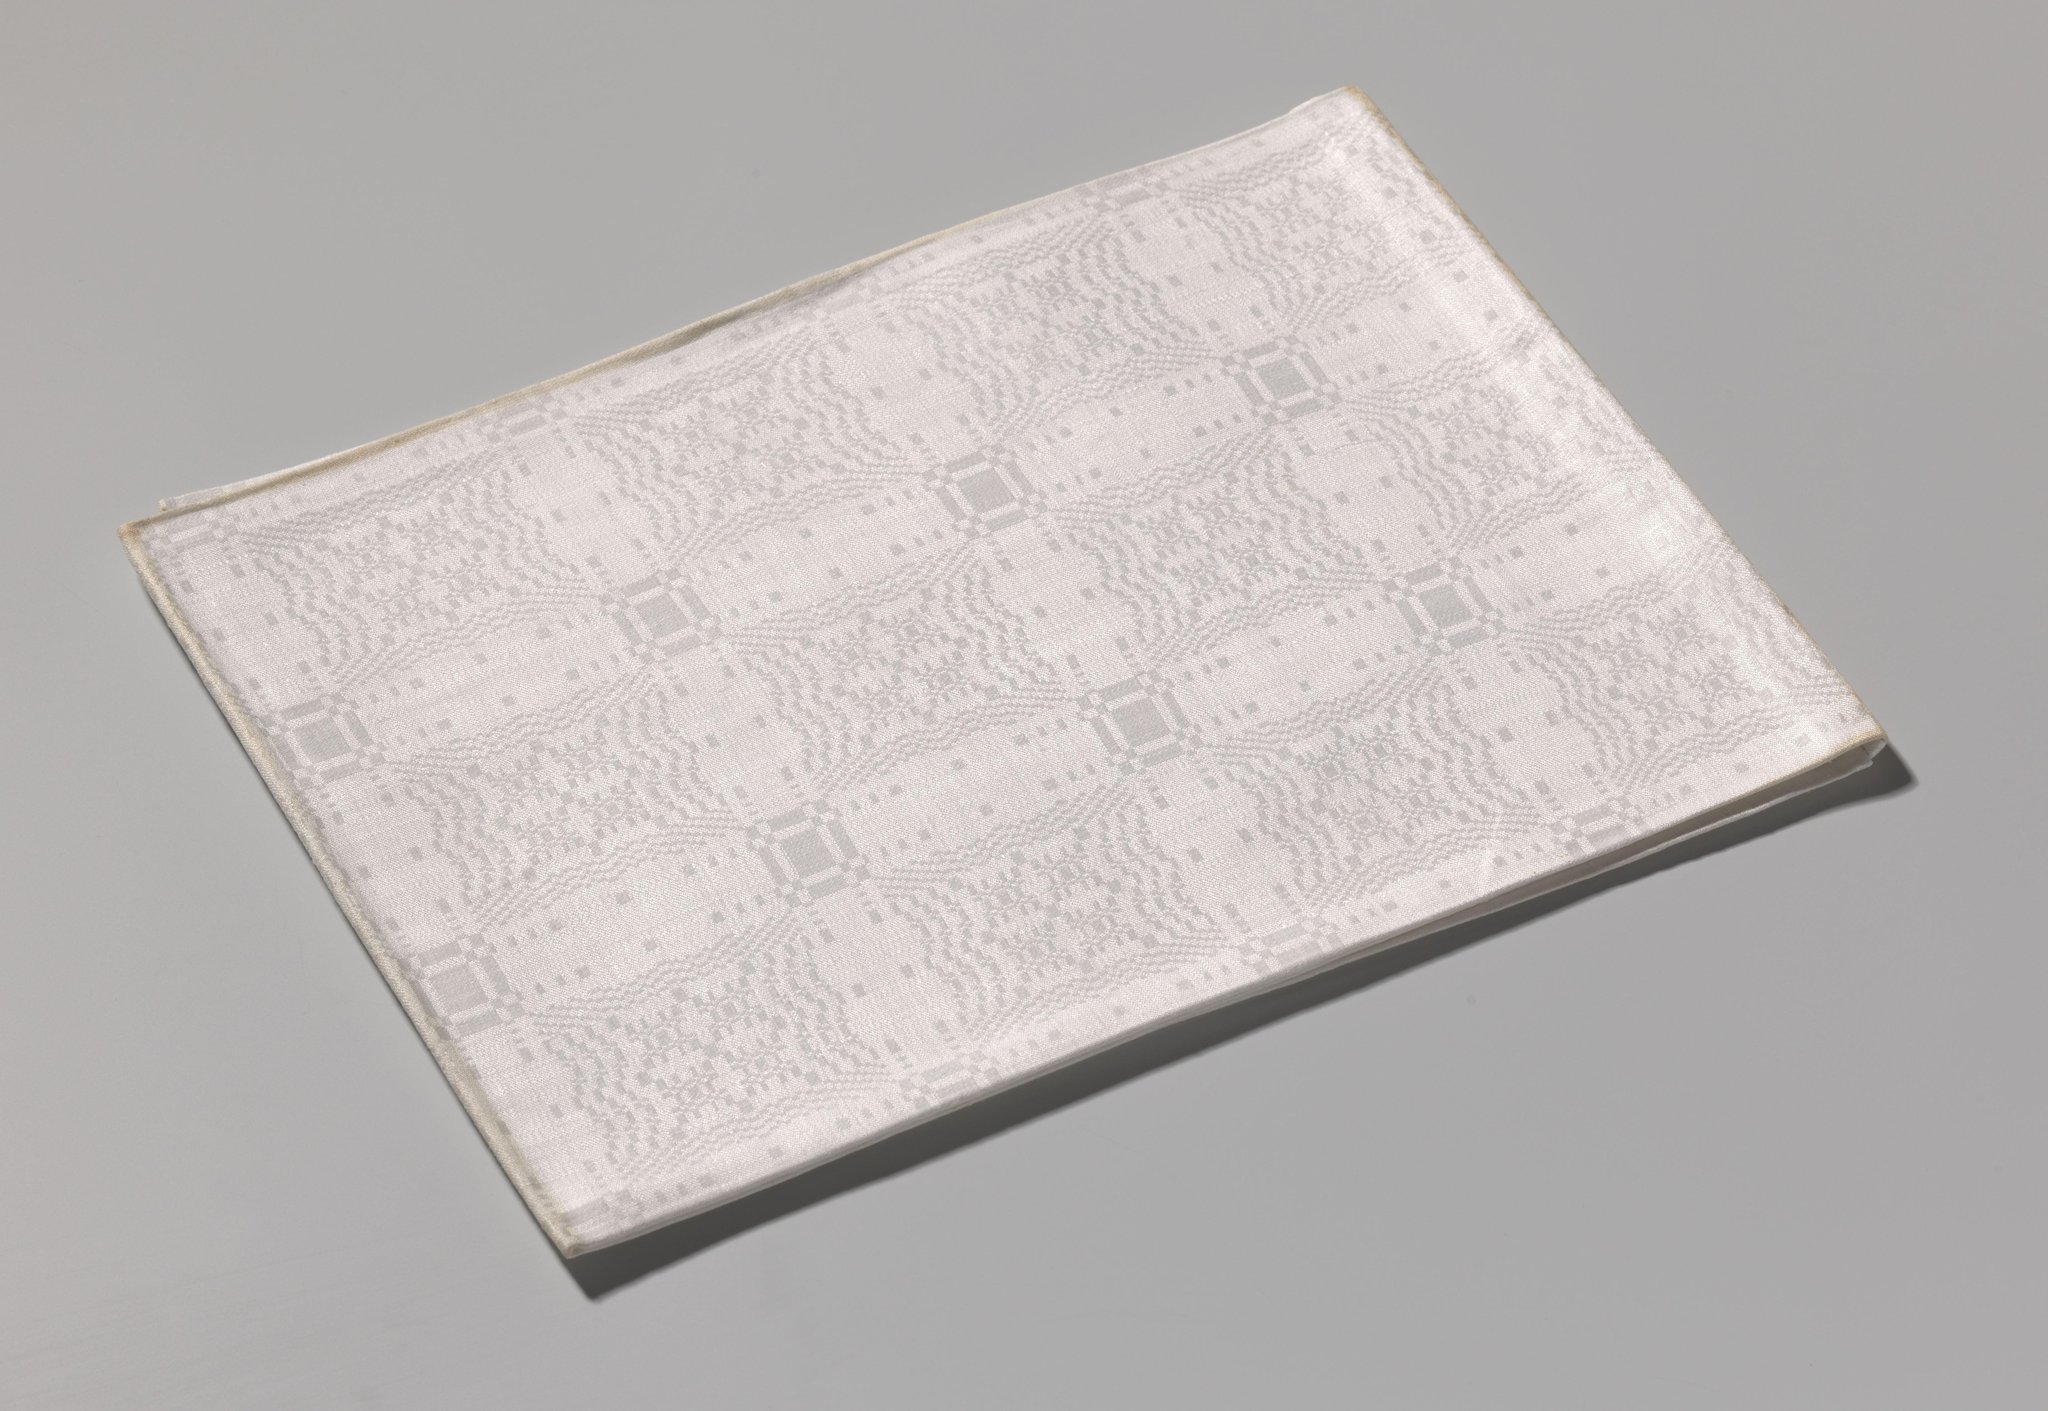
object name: napkin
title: Servet van linnen met pellenpatroon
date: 1400-1950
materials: linen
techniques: peeled fabric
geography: northern netherlands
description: Wit linnendamasten servet met pellenpatroon, merk kroon IS en 96.